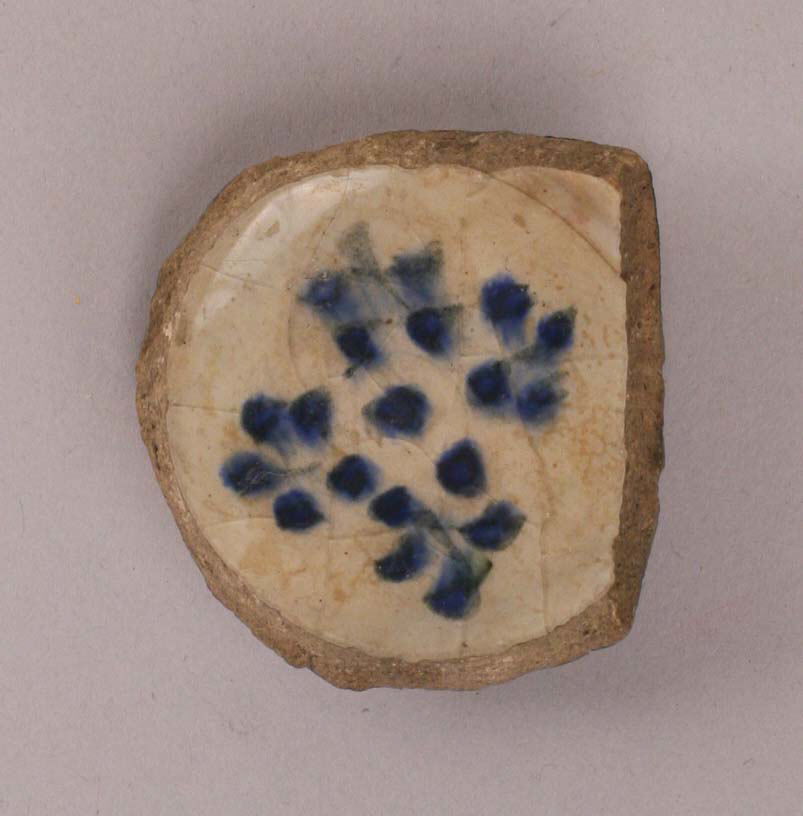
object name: fragment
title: Ceramic Fragment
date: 1301-1400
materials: glaze, stonepaste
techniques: painting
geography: egypt